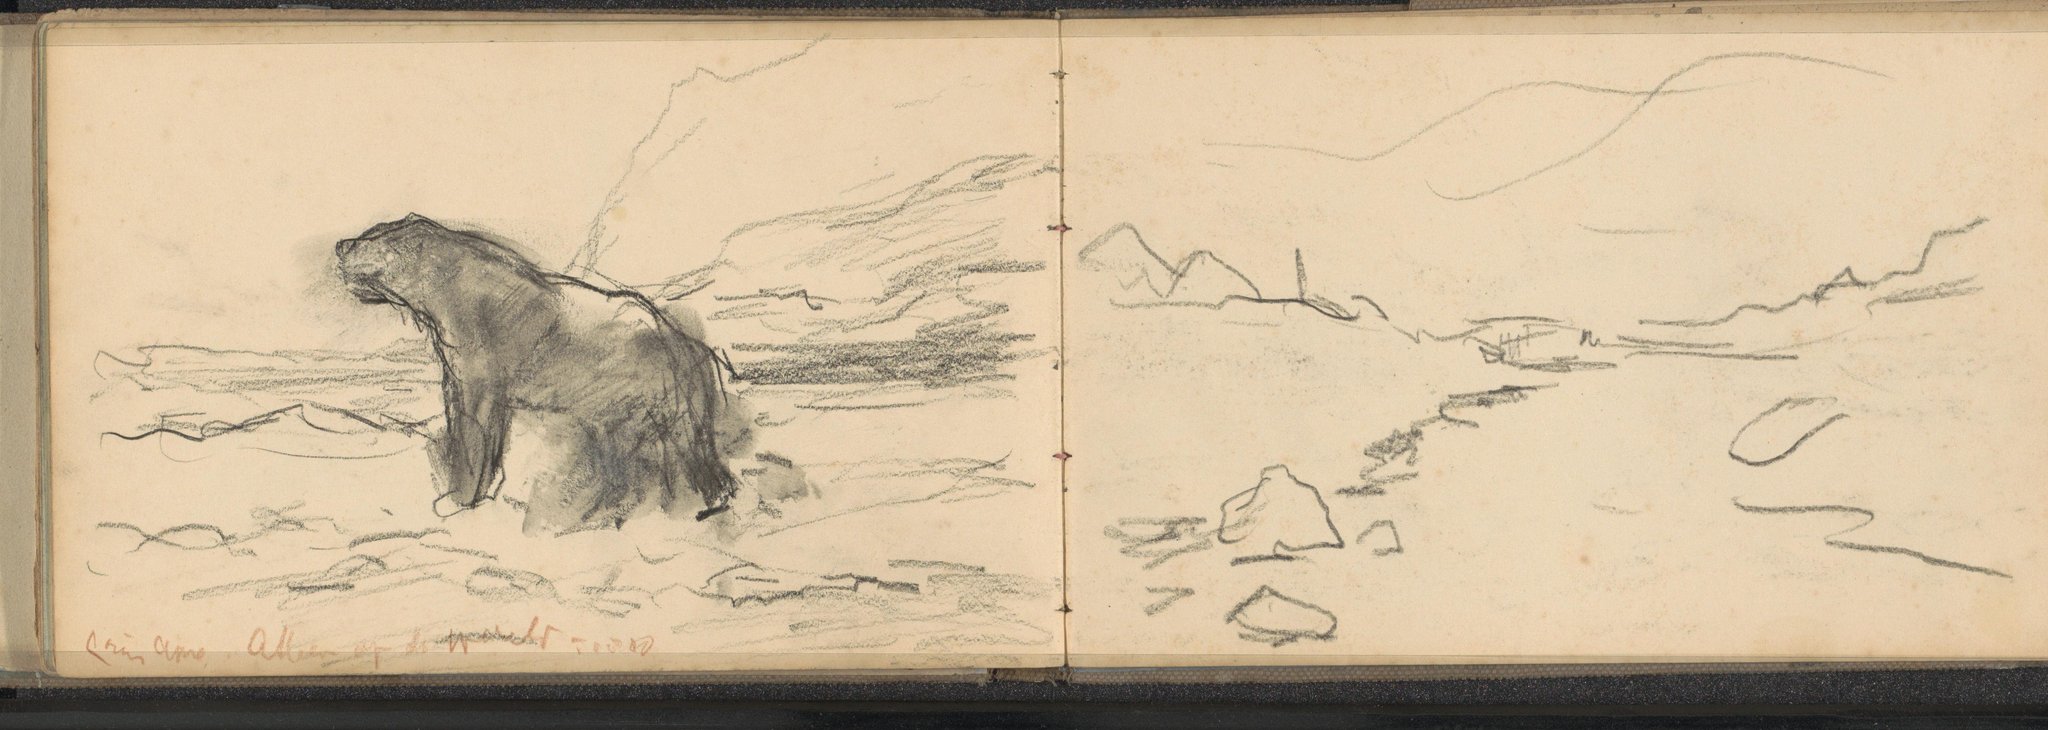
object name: sketchbook leaf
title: IJsbeer in een landschap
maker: louis apol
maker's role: draughtsman, painter, print maker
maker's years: 1850-1936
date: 1880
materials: chalk, paper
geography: norway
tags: beasts of prey, predatory animals: polar bear, coast (in polar regions)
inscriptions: date: ‘1880’, annotation: ‘Alleen op de wereld’, signature: ‘Louis Apol’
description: Blad 30 verso uit een schetsboek met 38 bladen betekend tijdens de expeditie naar Nova Zembla in 1880.